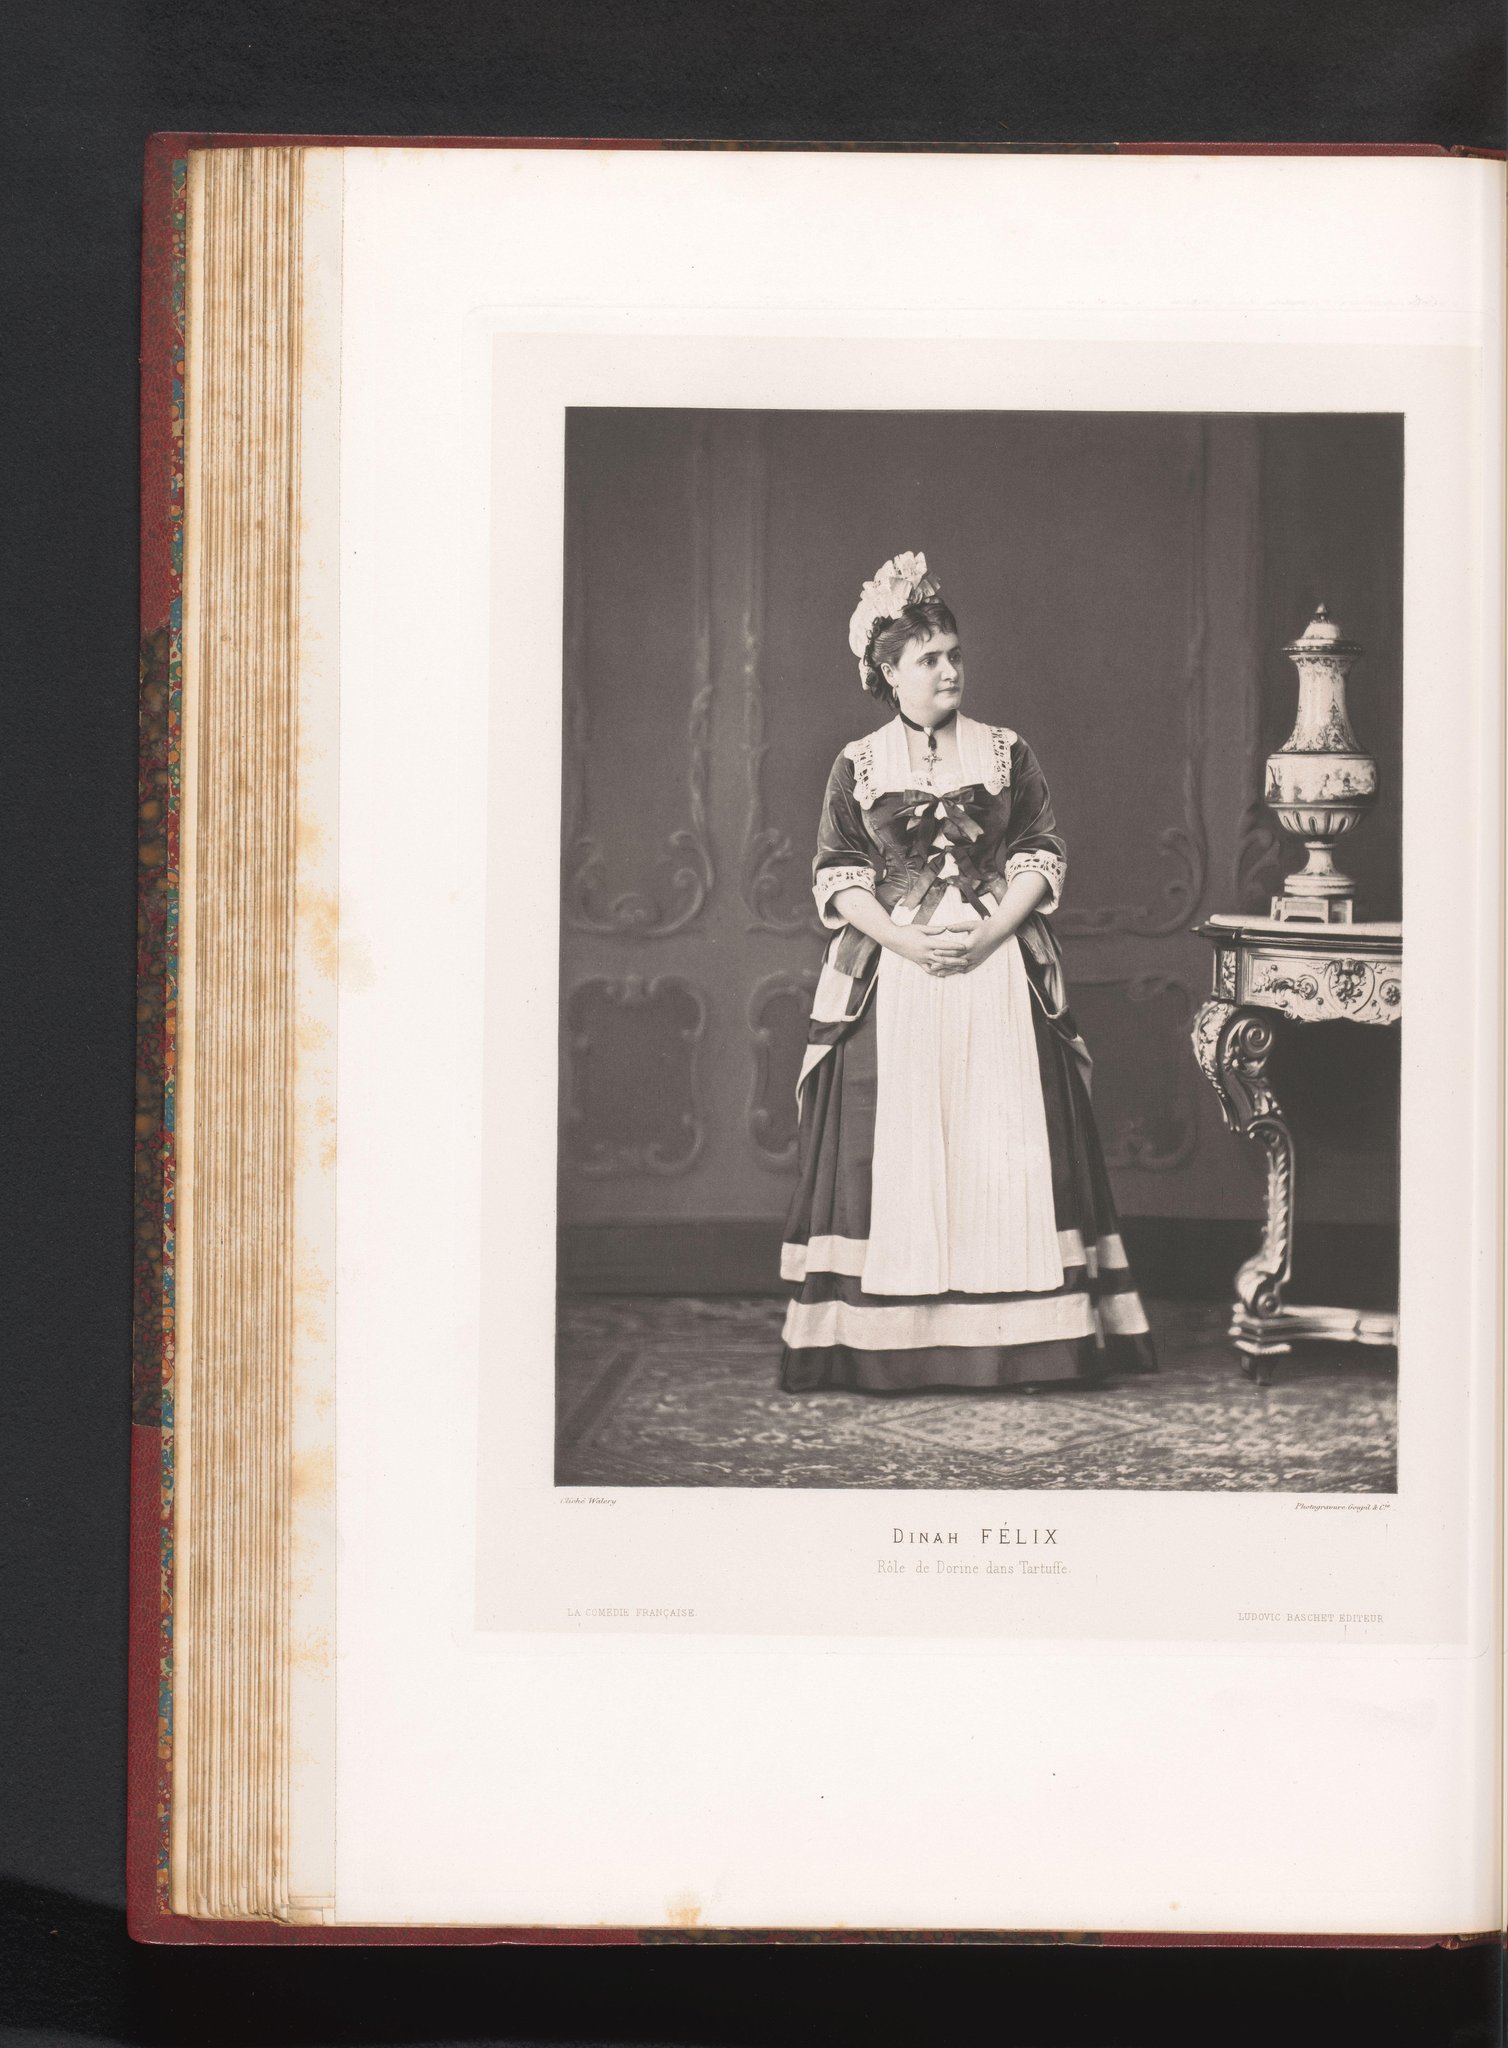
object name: photomechanical print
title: Portret van Mélanie-Émilie Dinah-Félix in de rol van Dorine in Tartuffe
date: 1875-1880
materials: paper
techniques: photoaquatint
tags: historical persons - bb - woman, portrait of actor, actress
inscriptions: inscription: ‘LA COMÉDIE FRANÇAISE’